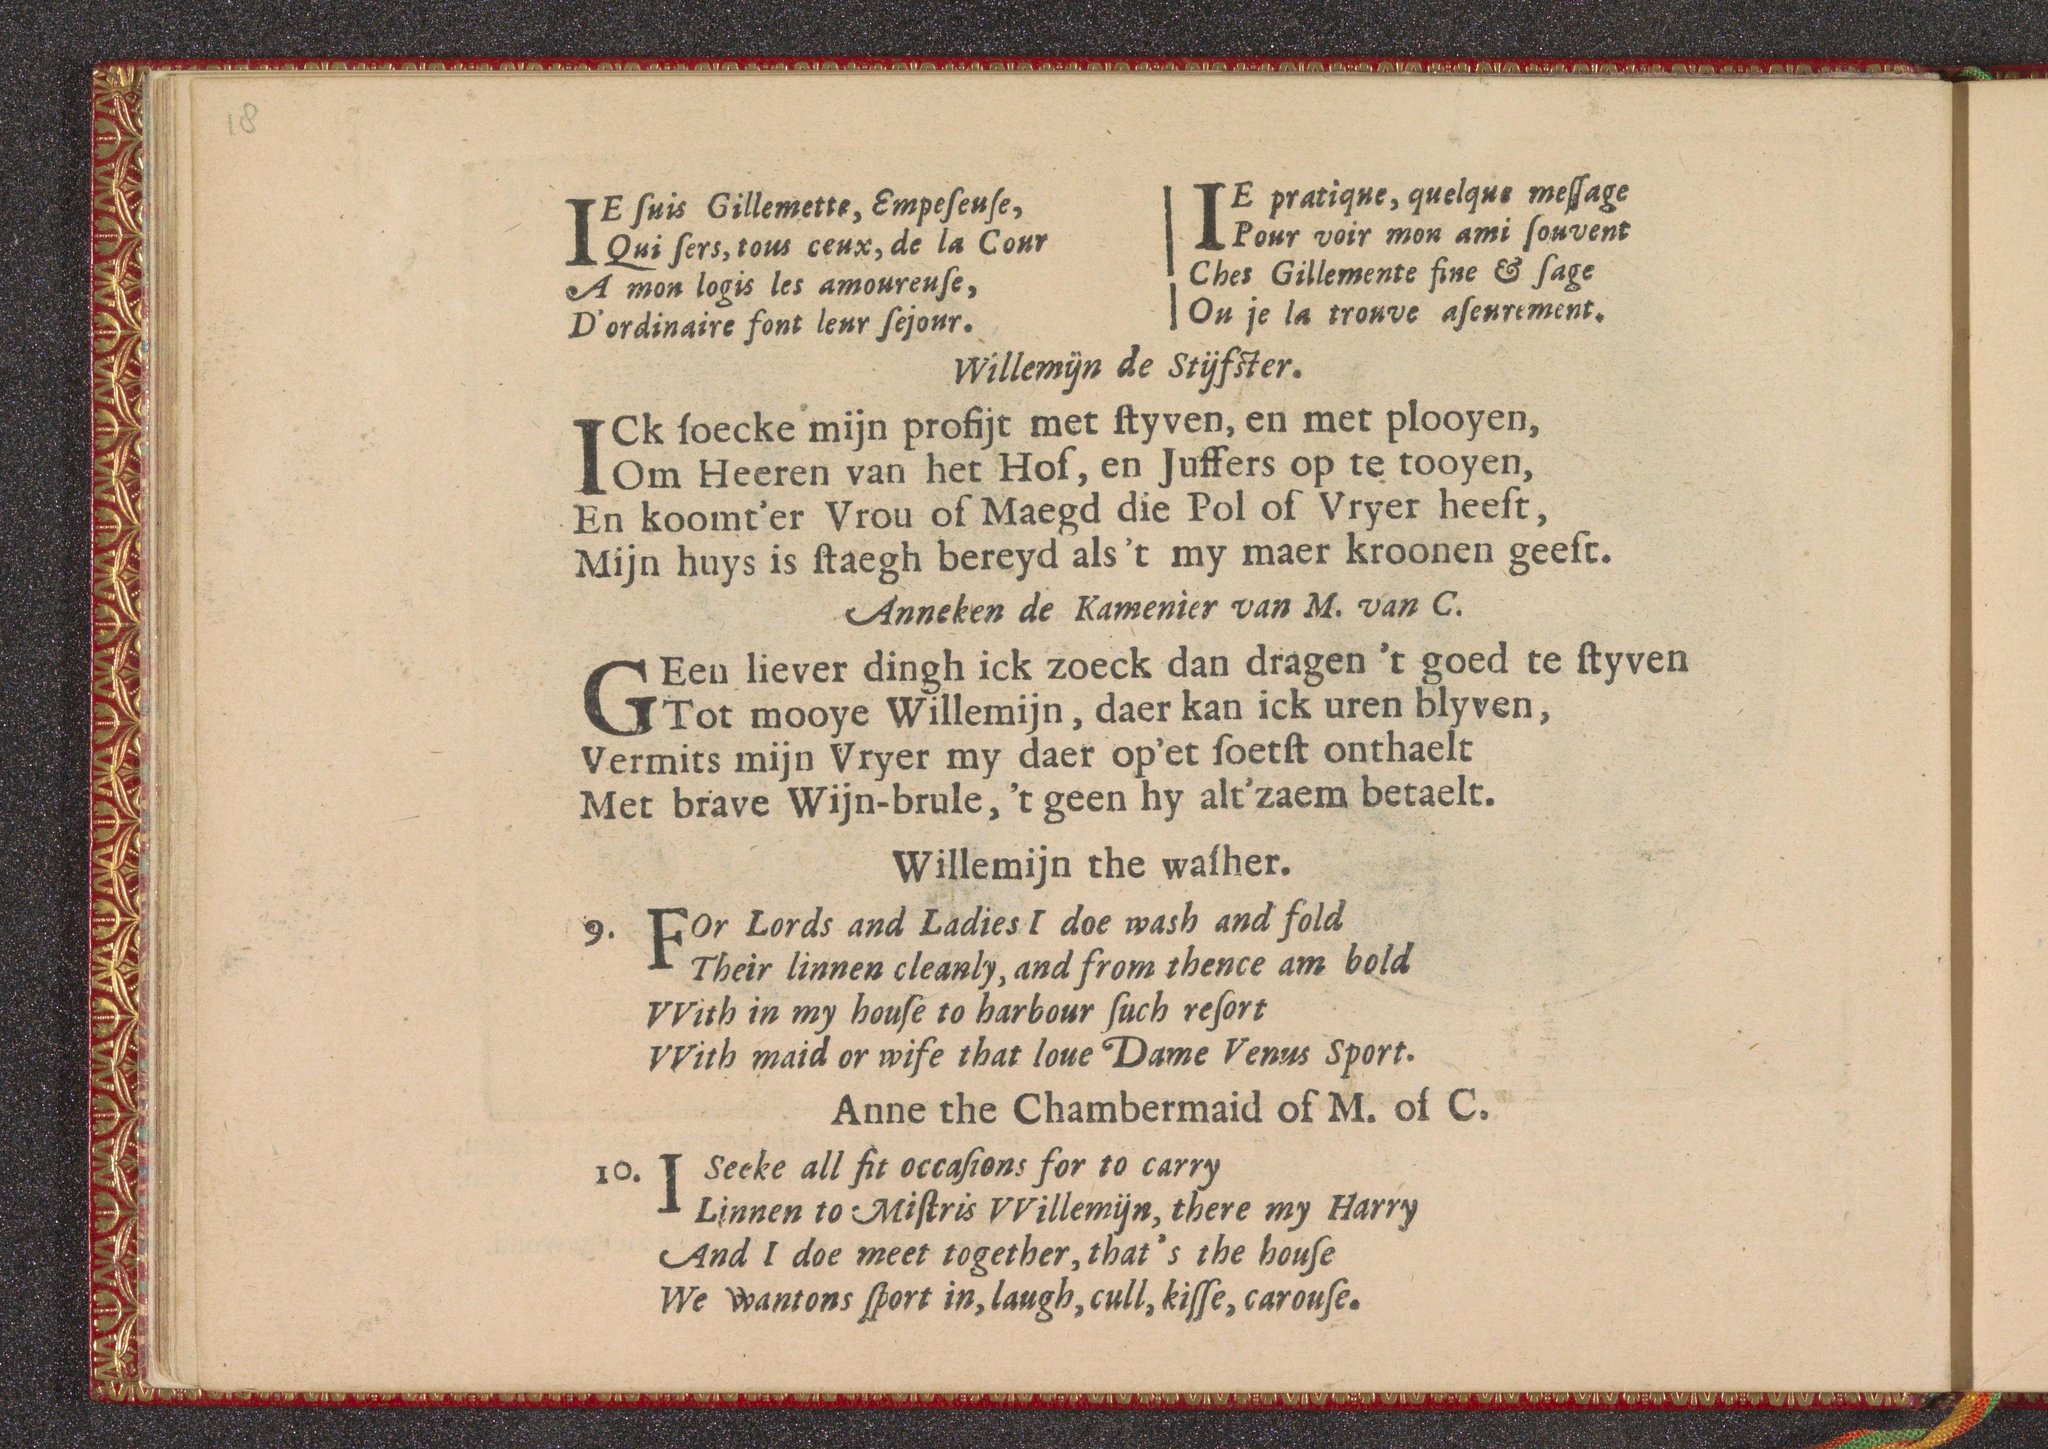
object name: album leaf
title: Kwatrijnen bij voorstellingen van een stijfster en een kamenierster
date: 1641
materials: paper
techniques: letterpress printing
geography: amsterdam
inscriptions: date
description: Drie keer twee kwatrijnen in het Frans, Nederlands en Engels bij voorstellingen van een stijfster en een kamenierster. Het blad maakt deel uit van een album.